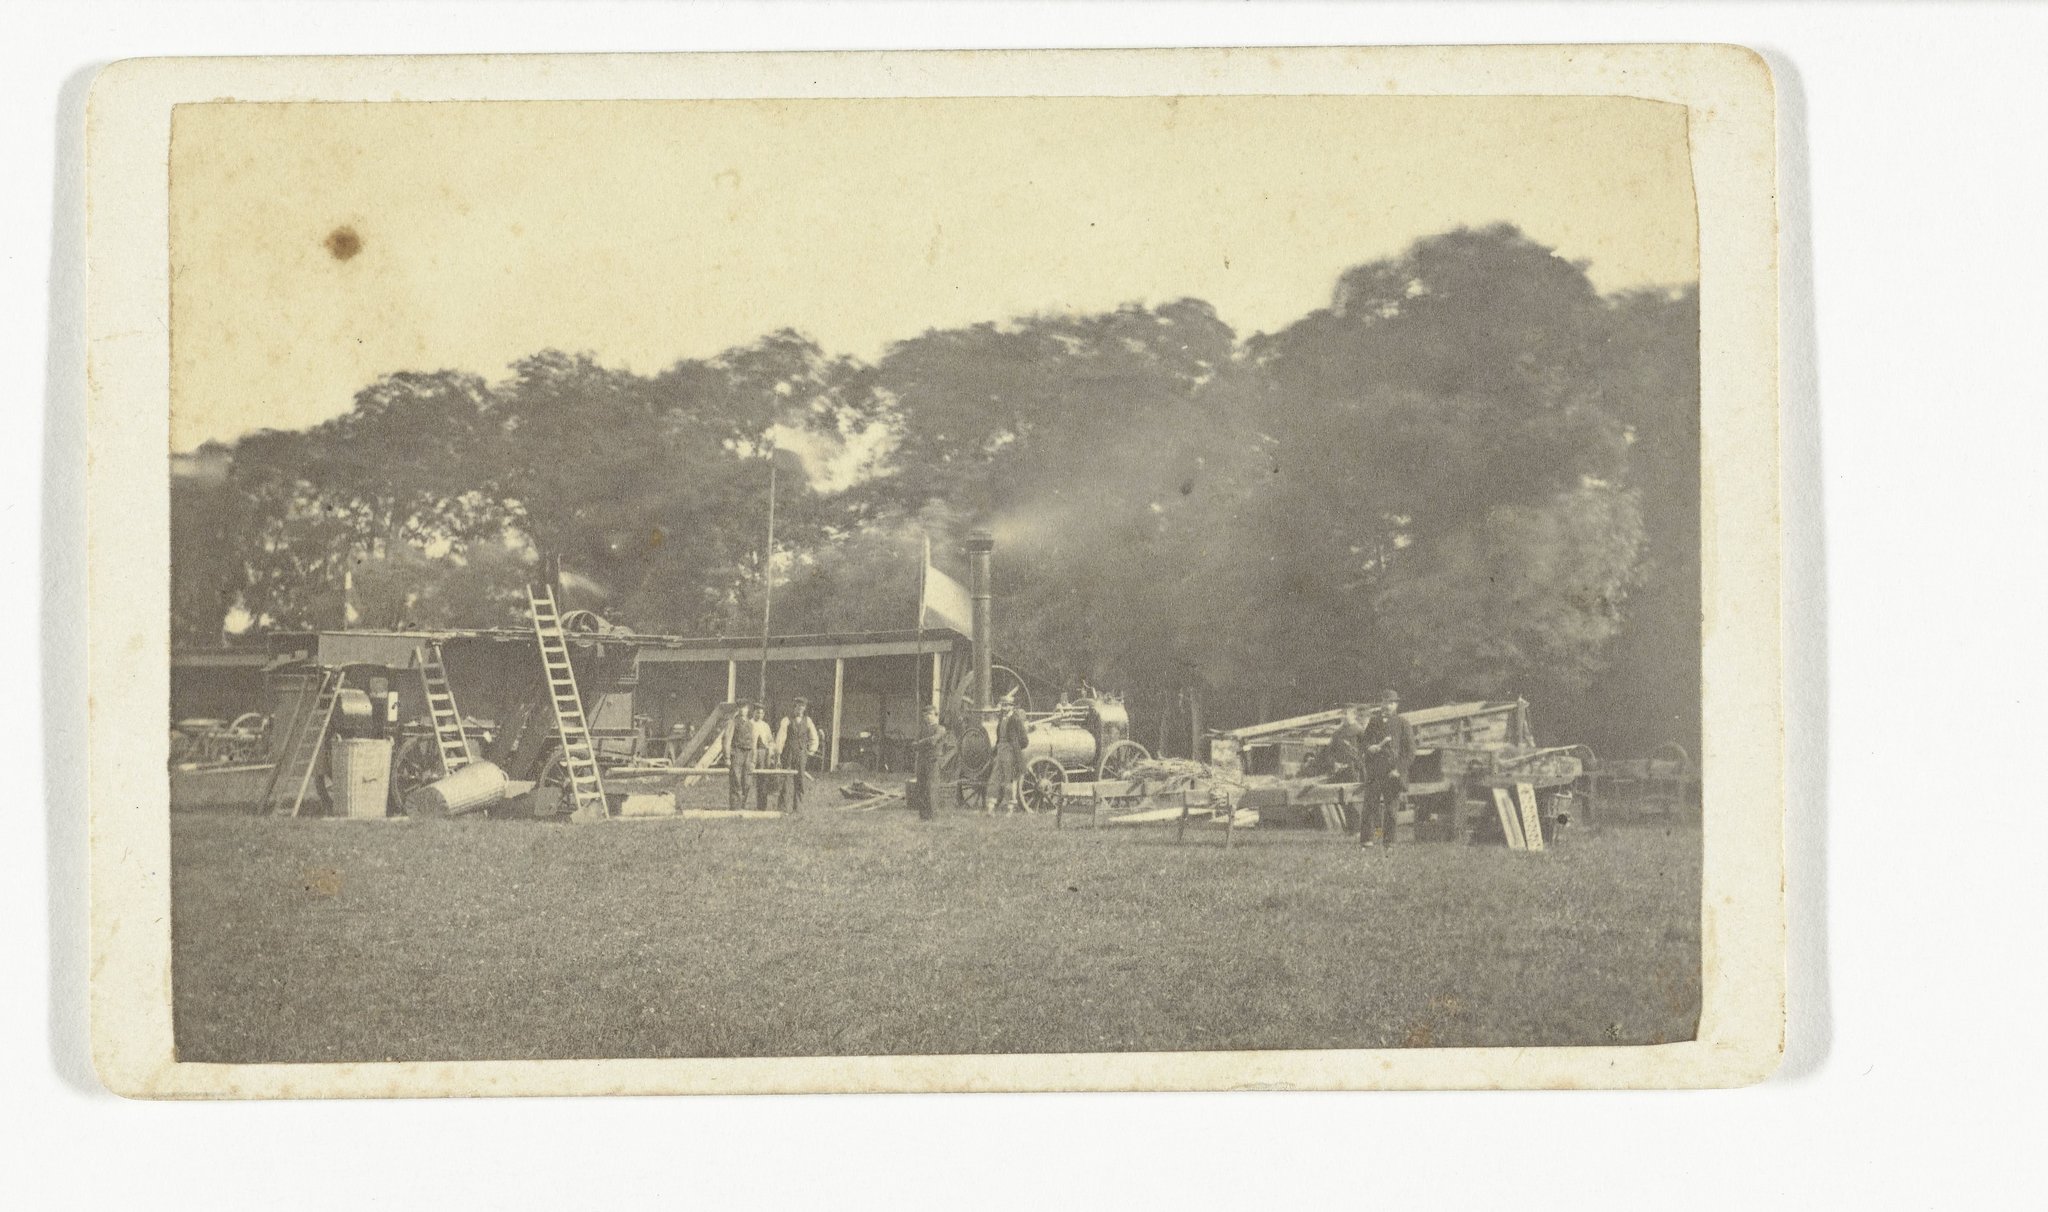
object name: carte de visite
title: Gezicht op een landbouwtentoonstelling in Middelburg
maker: jan wendel gerstenhauer zimmerman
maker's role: draughtsman, print maker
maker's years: 1816-1887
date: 1862-1870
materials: cardboard, photographic support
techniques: albumen print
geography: middelburg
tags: collection, exhibition, show, agriculture, middelburg